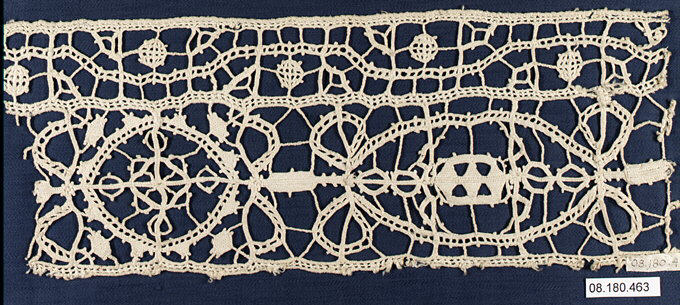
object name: fragment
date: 1601-1700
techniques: lace